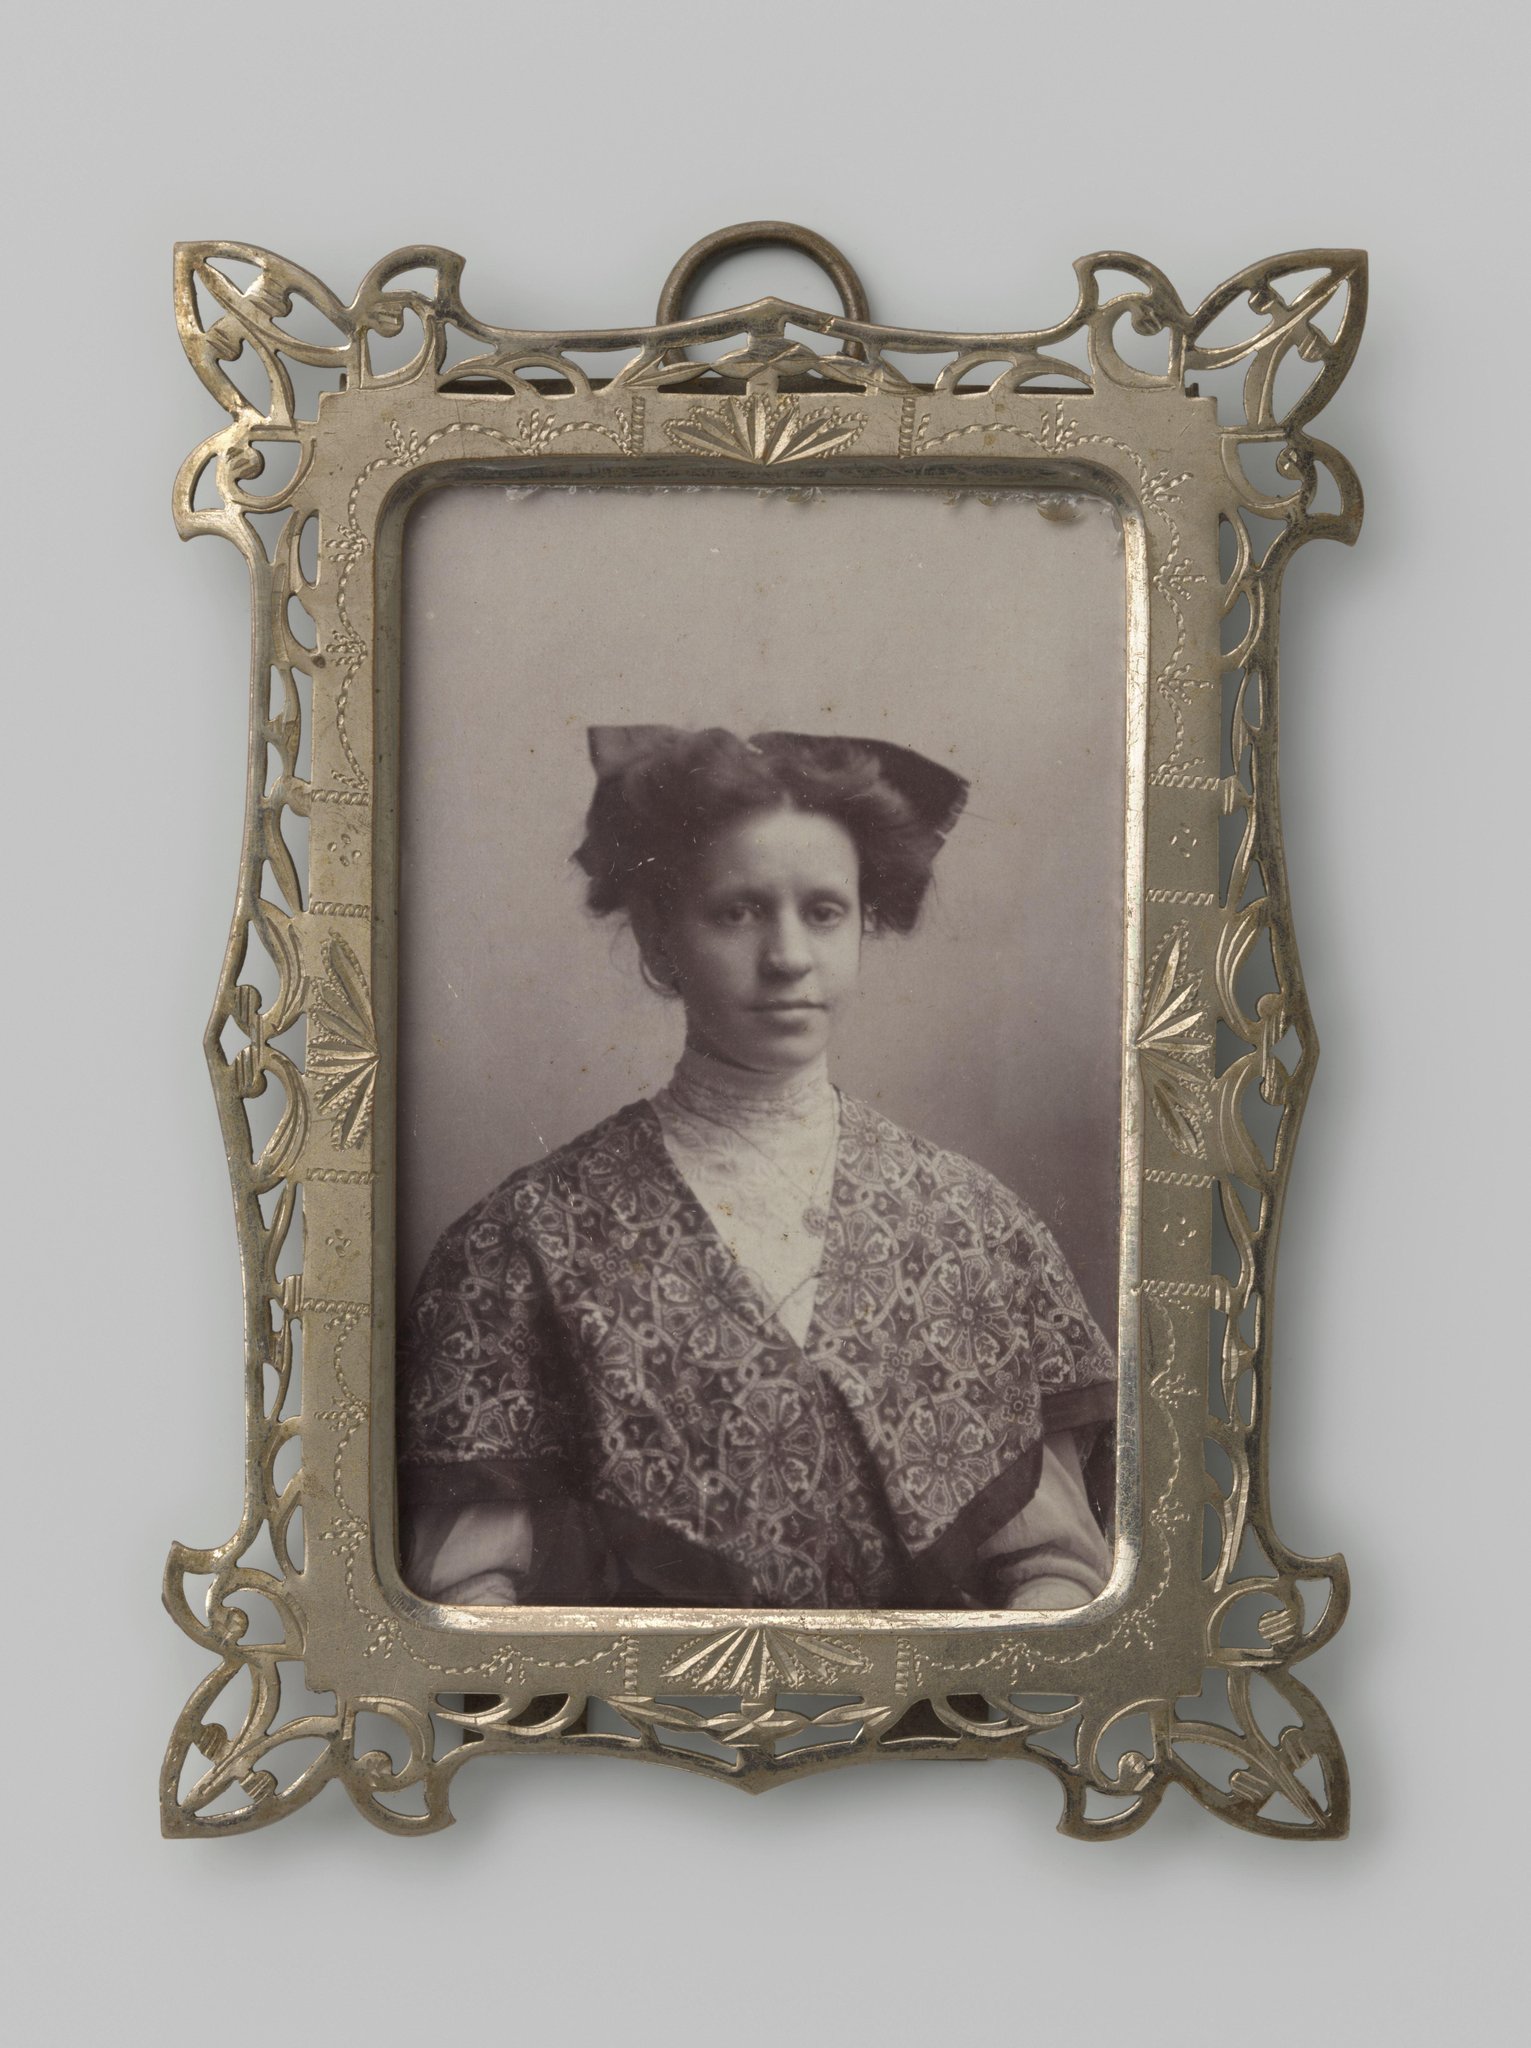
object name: frame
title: Portret van een onbekende vrouw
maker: Anonymous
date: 1890-1910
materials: paper, cardboard, glass, metal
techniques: collodion silver print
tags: adolescent, young woman, maiden, anonymous historical person portrayed